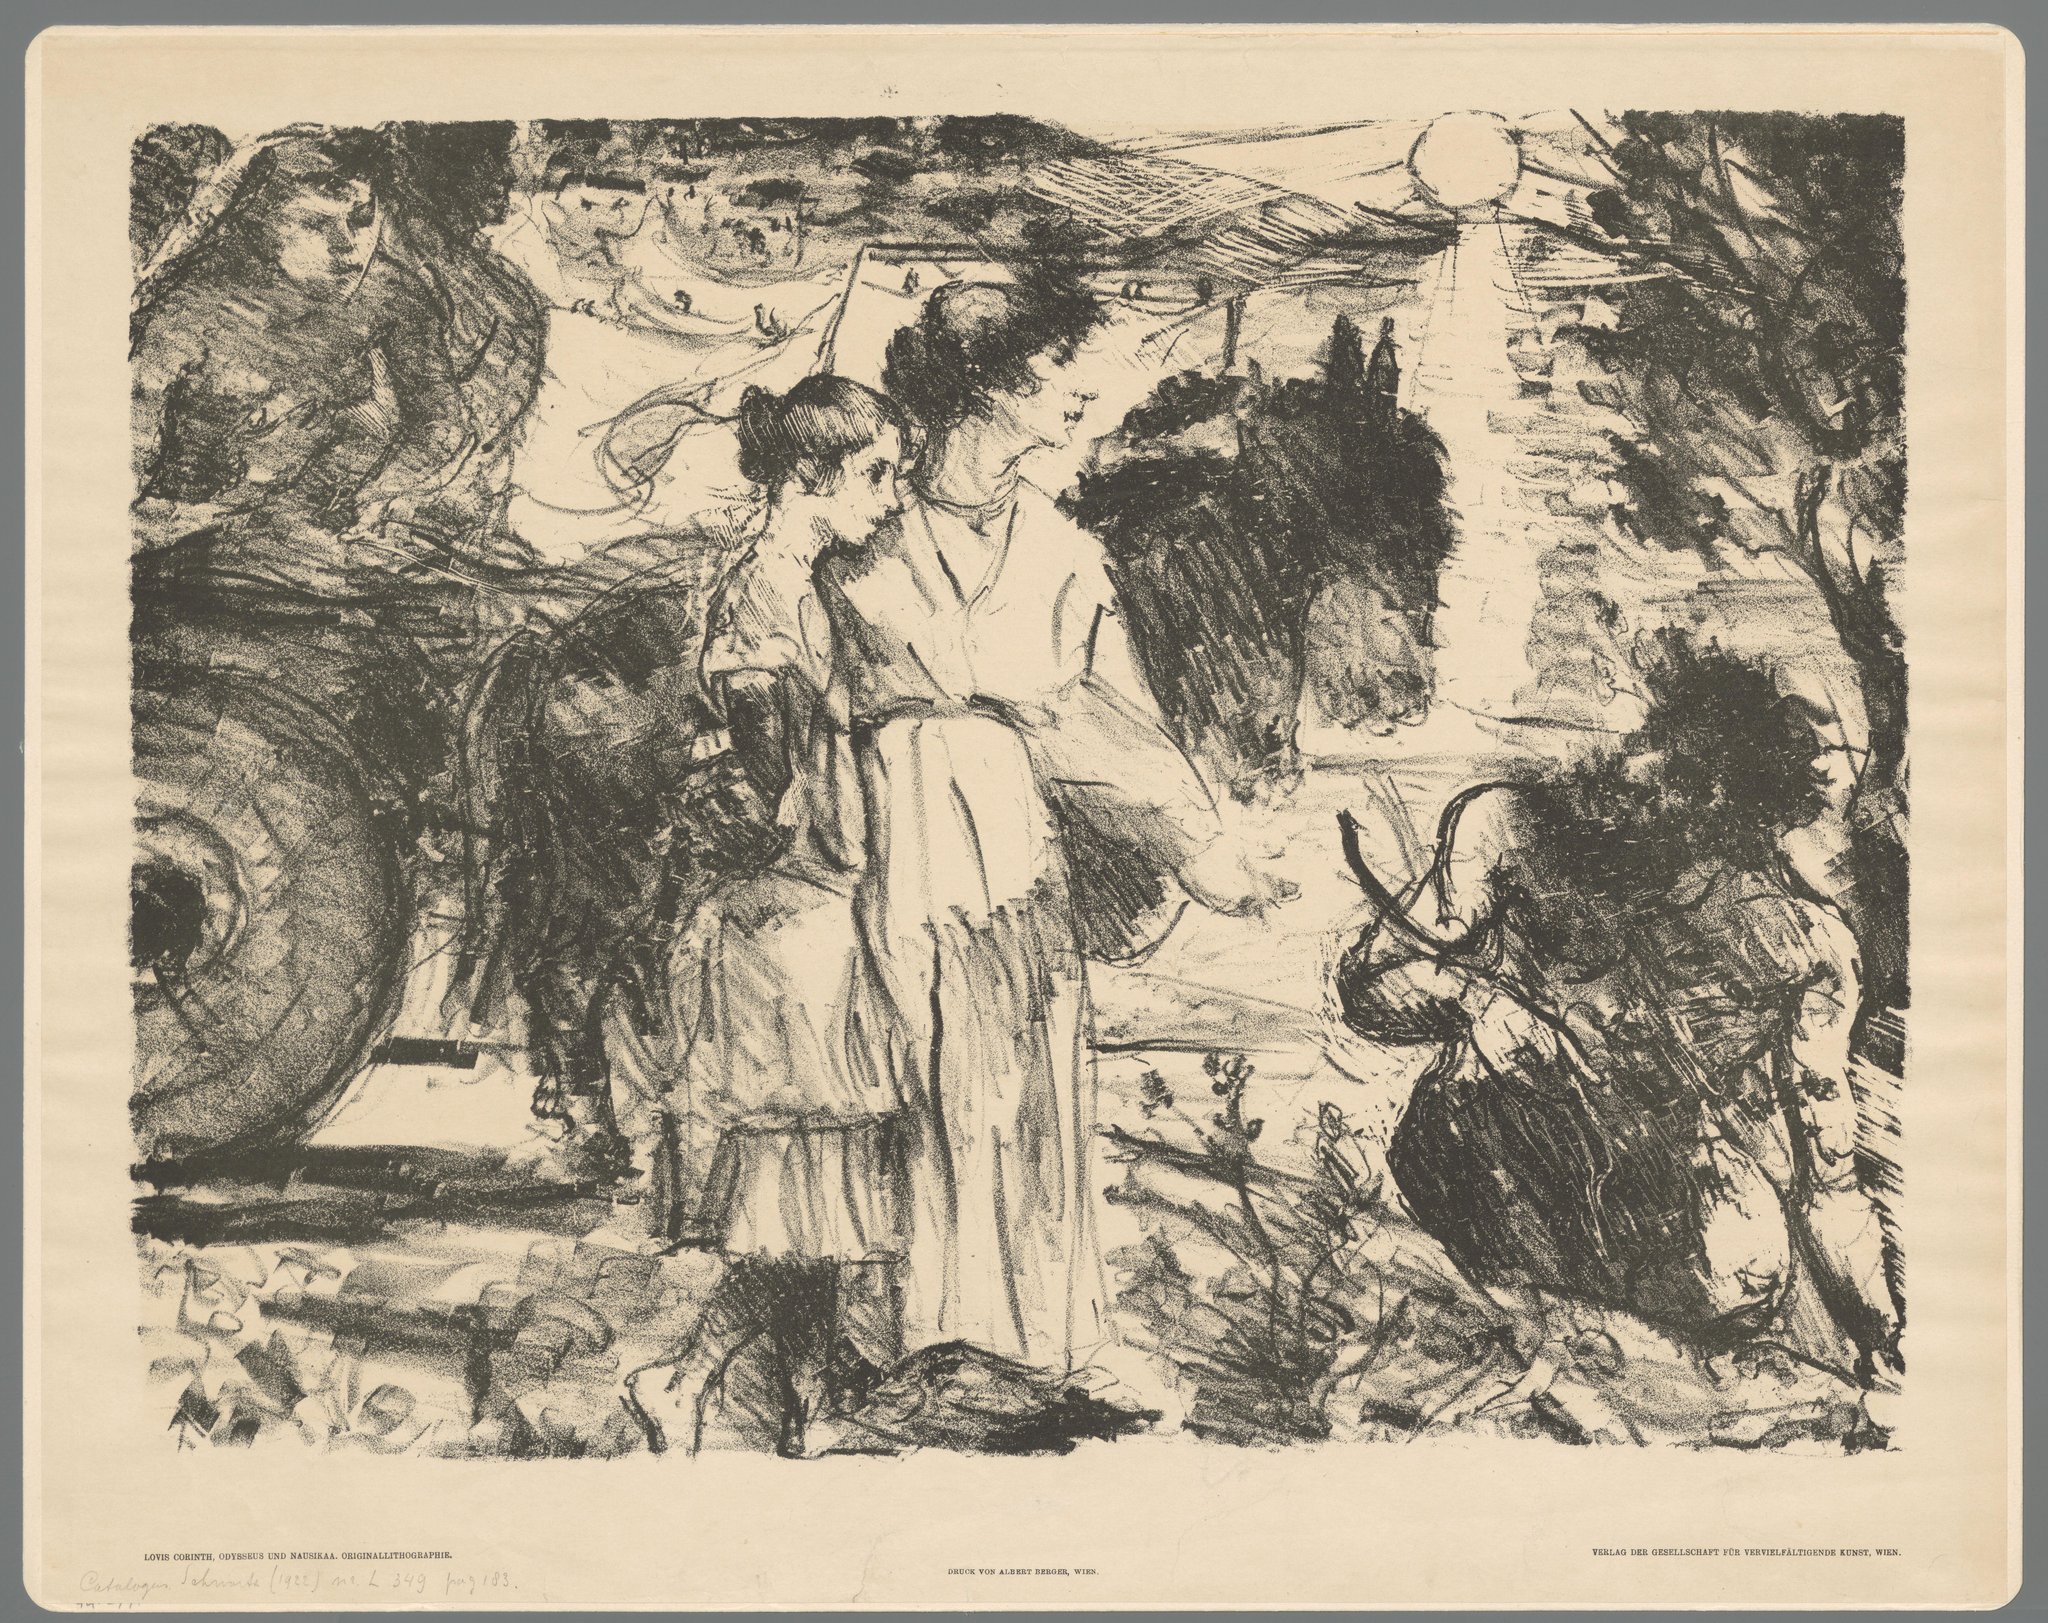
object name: print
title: Odysseus und Nausikaa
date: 1868-1925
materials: paper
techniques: lithography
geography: vienna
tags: meeting of nausicaa and ulysses: ulysses, almost naked, comes out of the bushes; nausicaa and her companions are startled at the sight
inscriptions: collector's mark: Lugt 2228